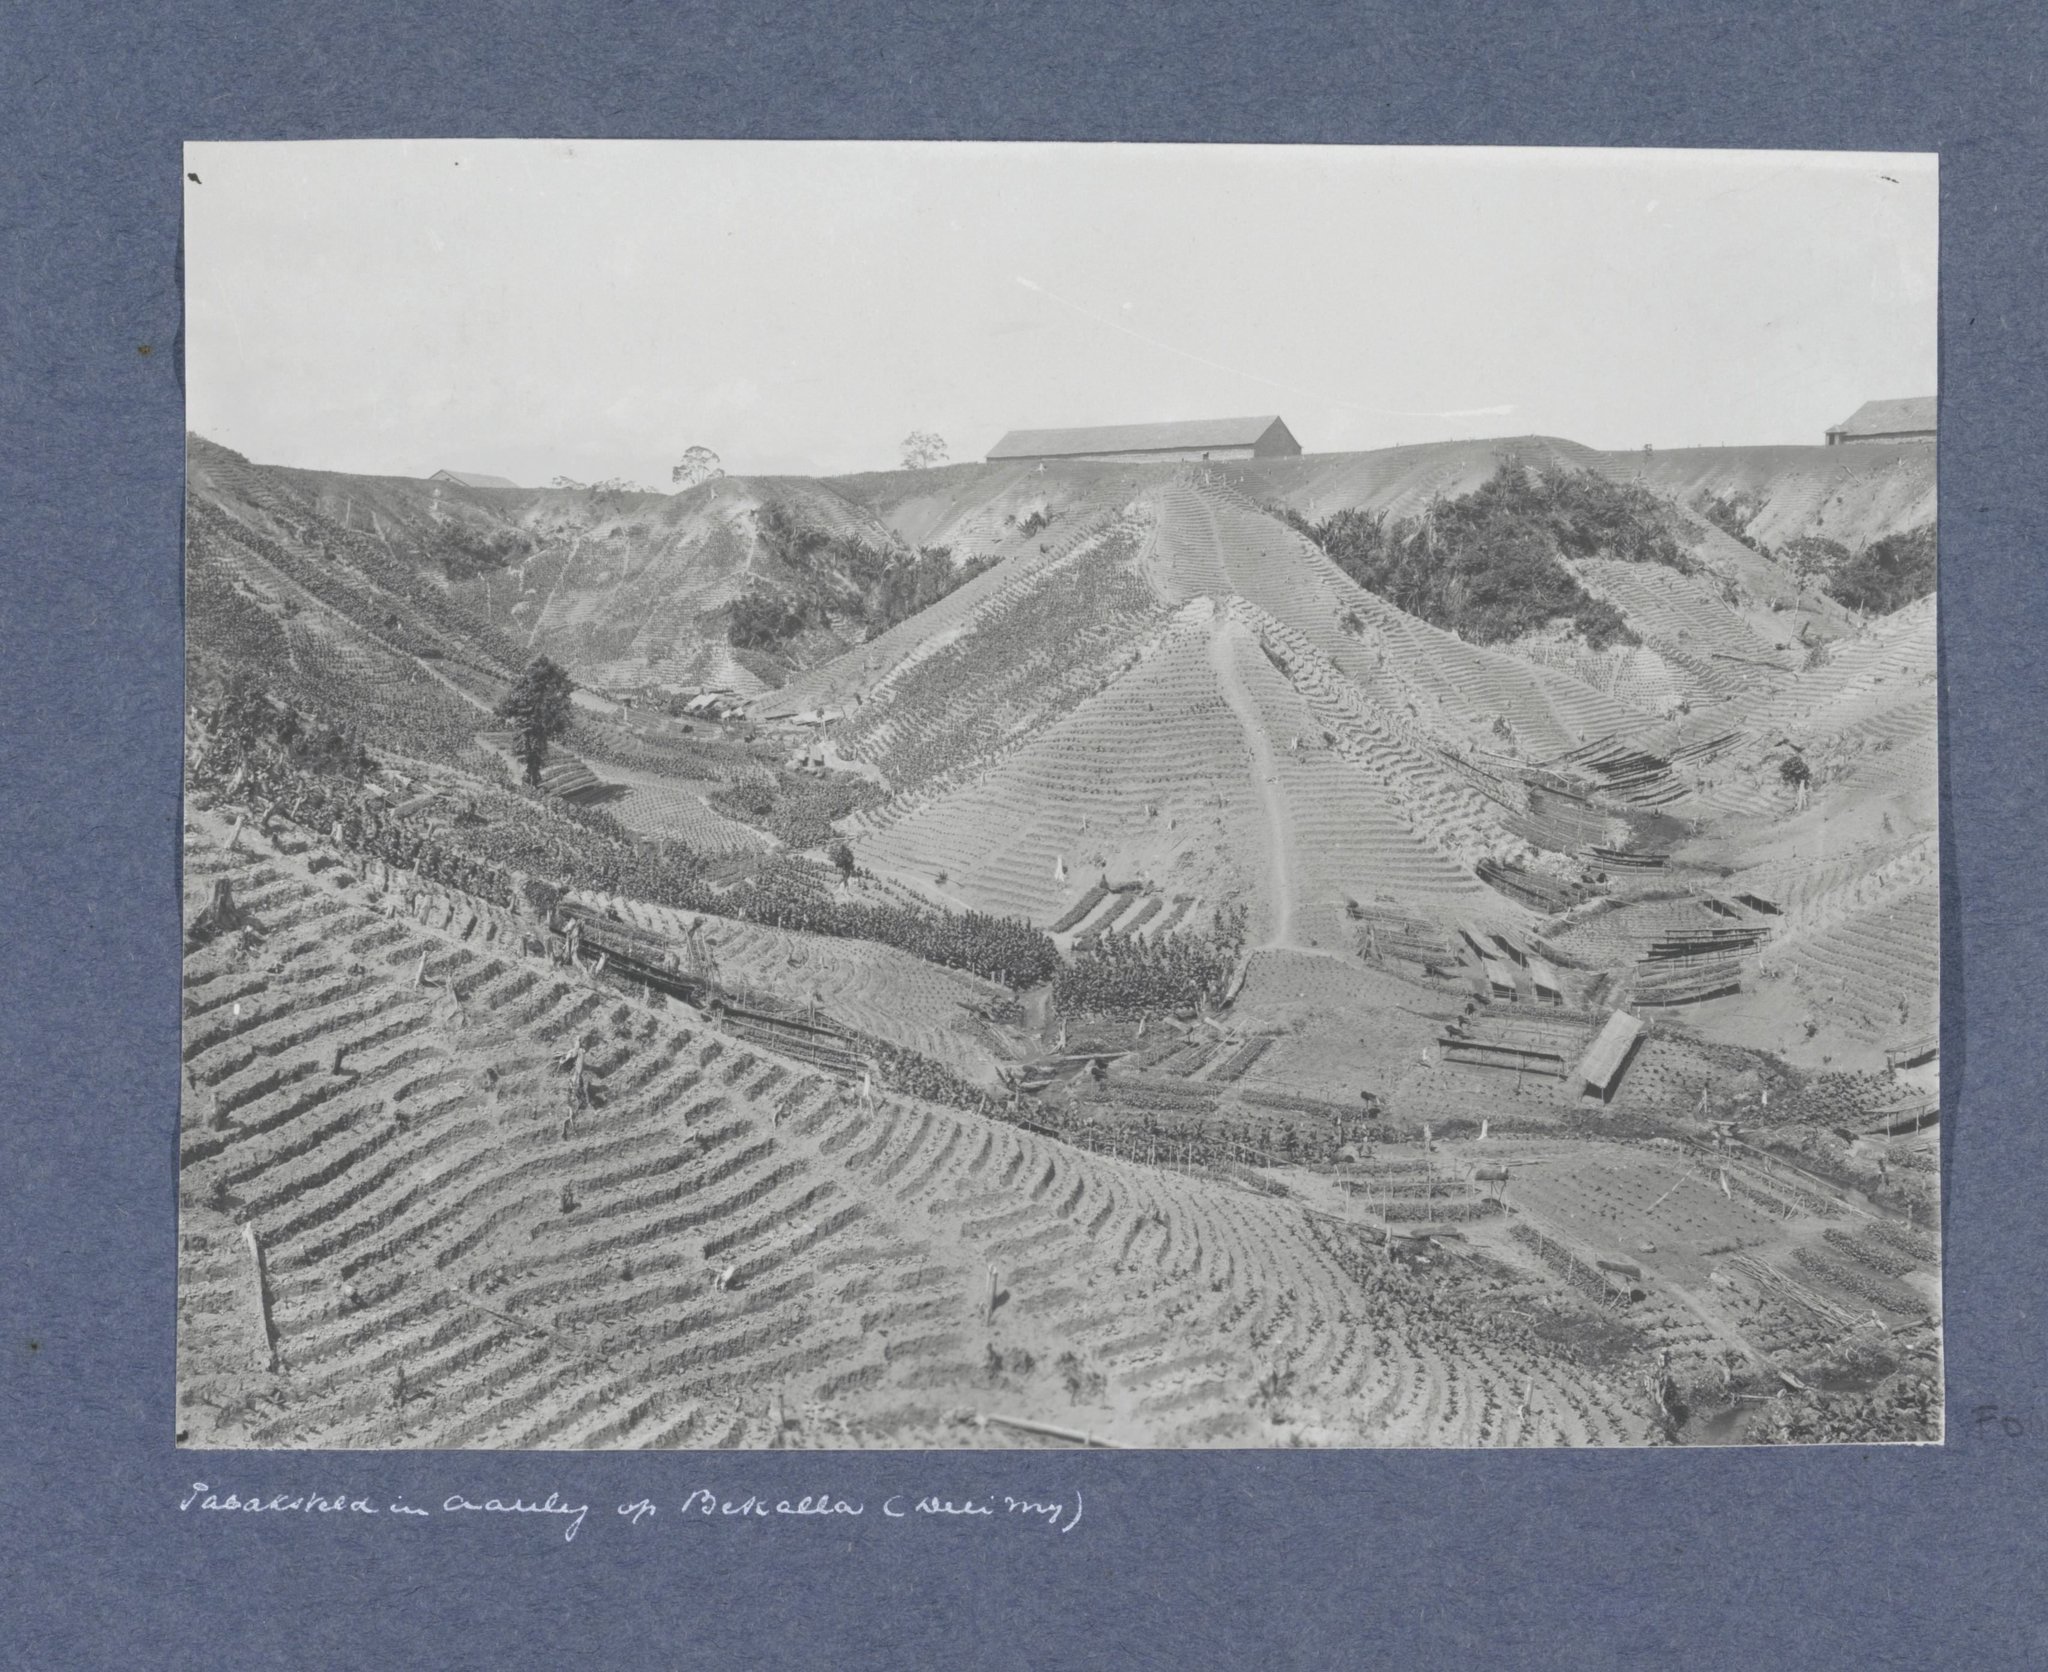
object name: photograph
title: Tabaksveld in aanleg op tabaksplantage Bekalla van de Deli Maatschappij op Sumatra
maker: Anonymous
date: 1900-1920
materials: paper, photographic support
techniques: gelatin silver print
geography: sumatra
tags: plantation, (high) hill, tobacco, sumatra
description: Onderdeel van reisalbum met foto's van bedrijvigheid en bezienswaardigheden op Sumatra en Java en van de reis naar en van Nederlands-Indië.